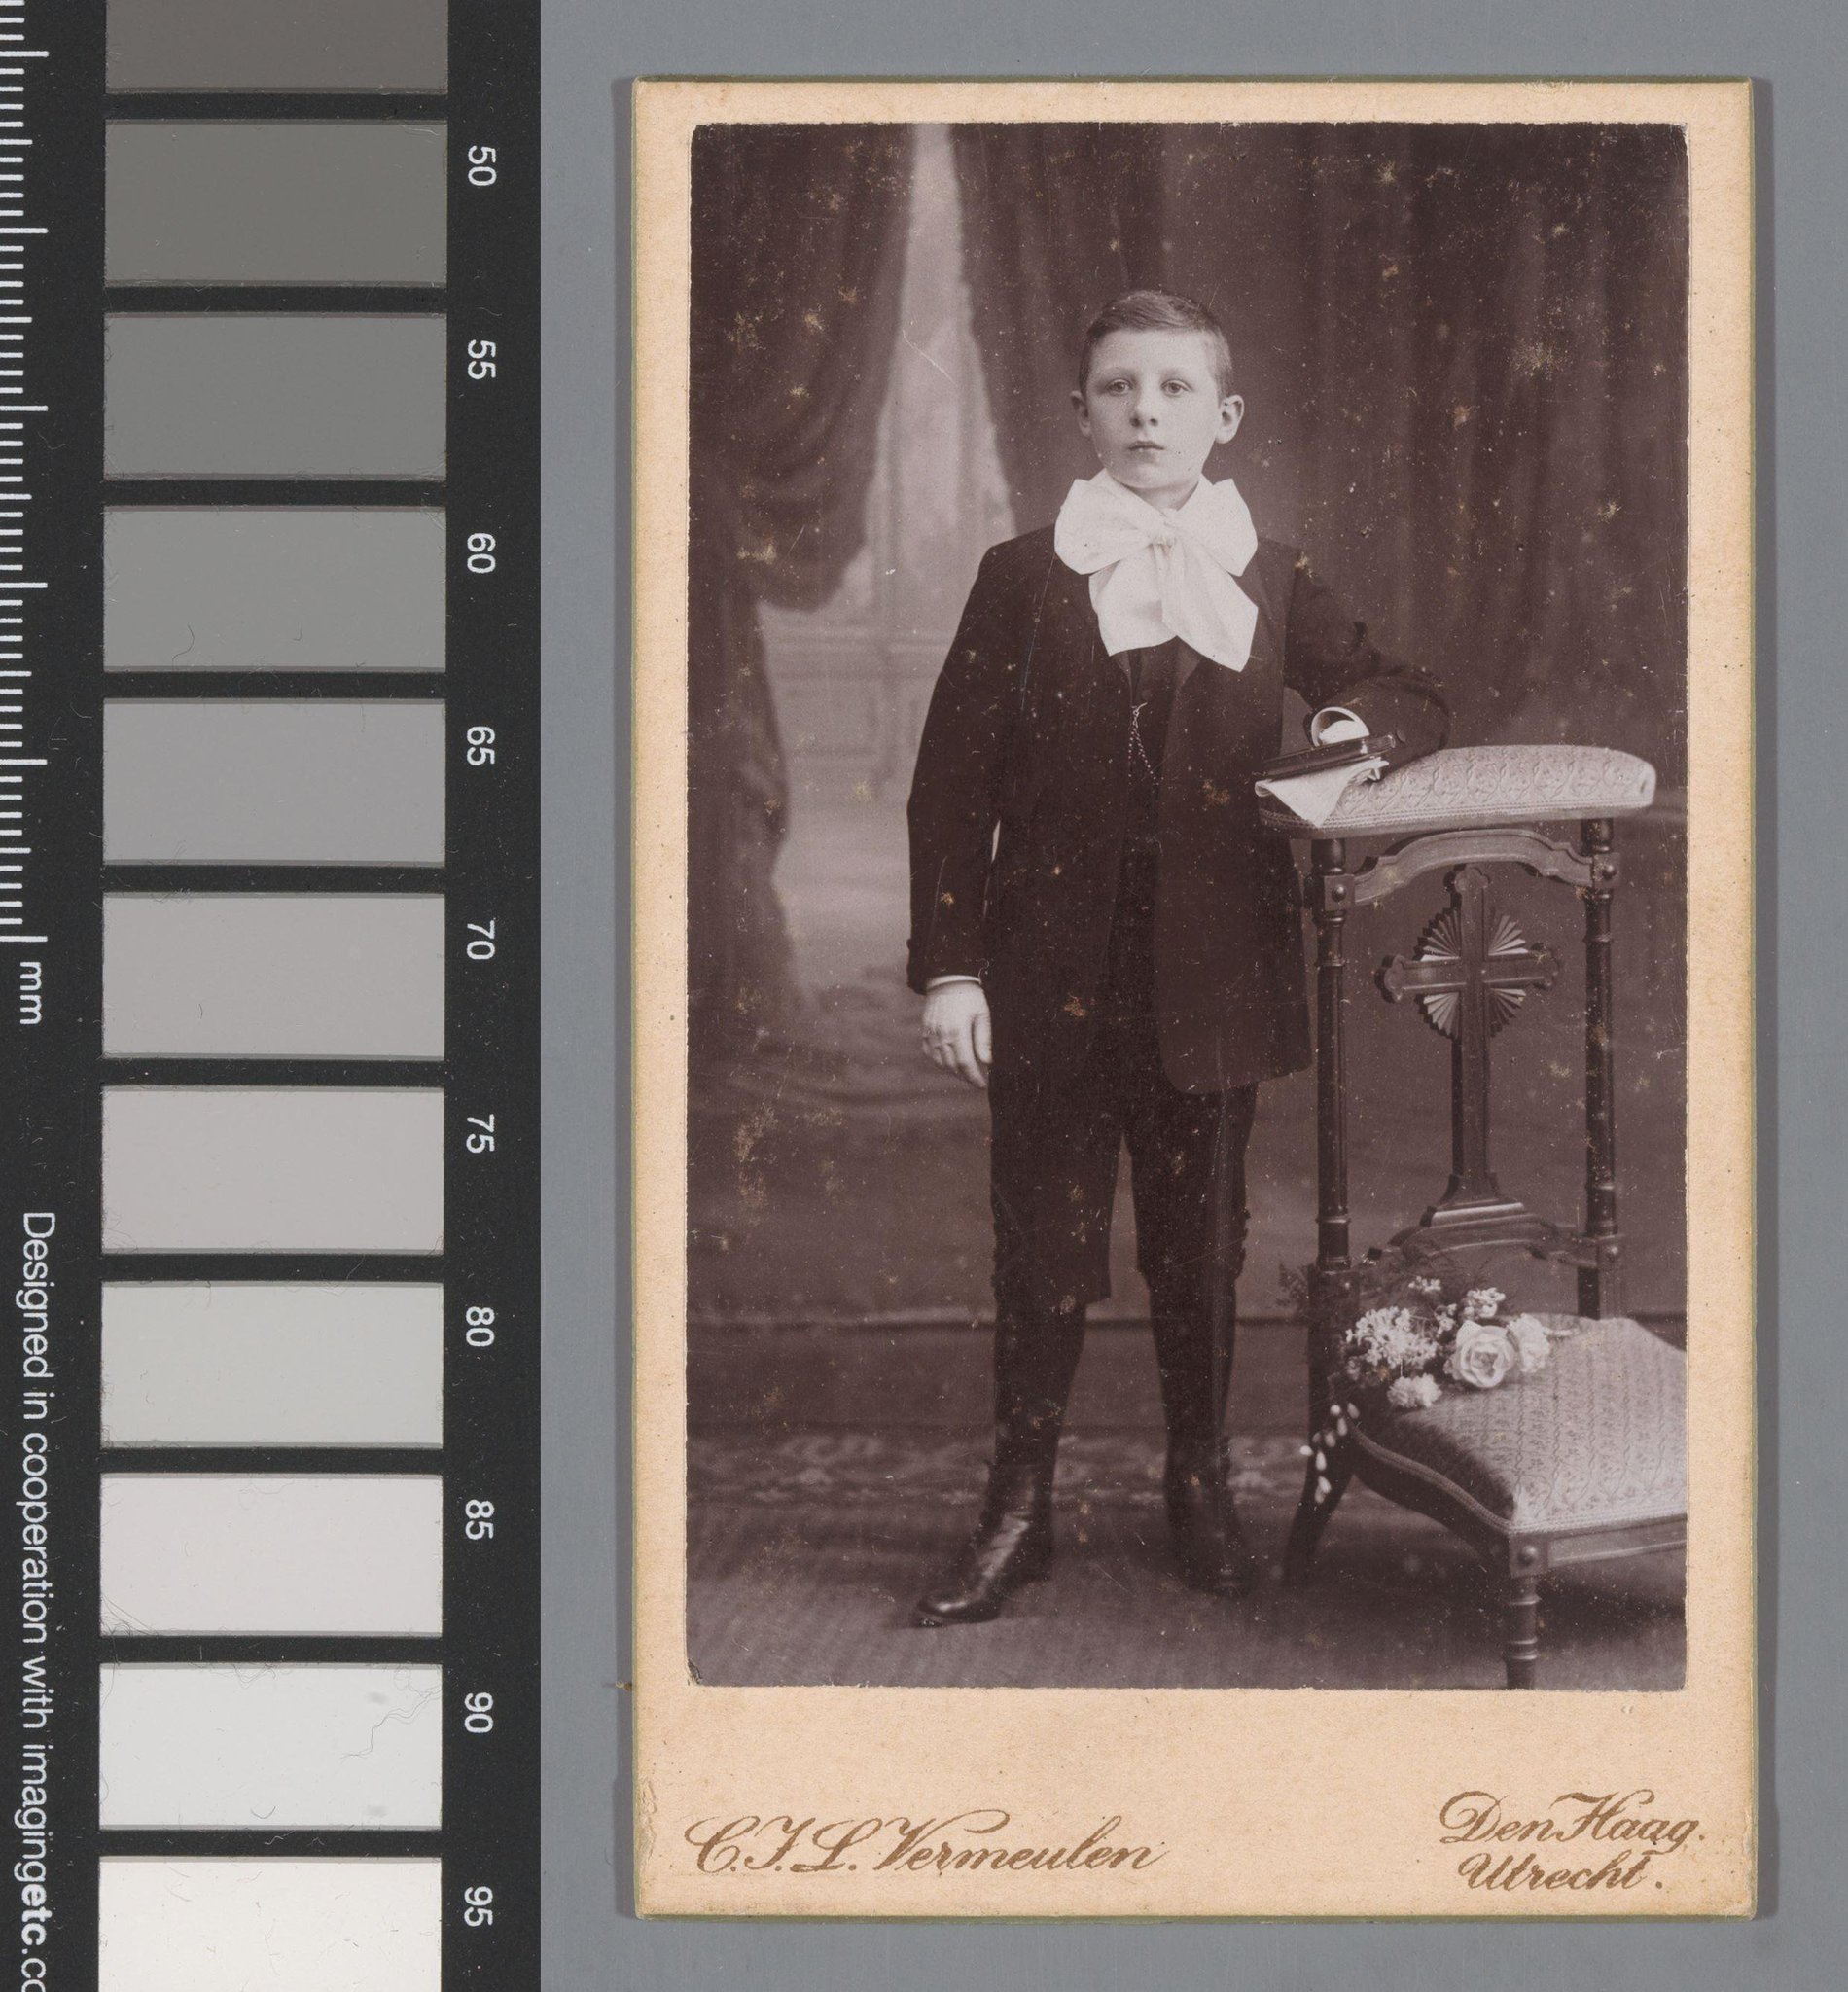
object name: photograph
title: Portret van een onbekende jongen gekleed in een pak voor de eerste heilige communie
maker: cornelis johannes lodewicus vermeulen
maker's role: fotograaf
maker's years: 1861-1936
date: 1898-1930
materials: cardboard, photographic support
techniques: daylight paper print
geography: netherlands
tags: first communion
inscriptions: name: ‘C.J.L. Vermeulen Atelier voor Moderne Fotografie (...)’